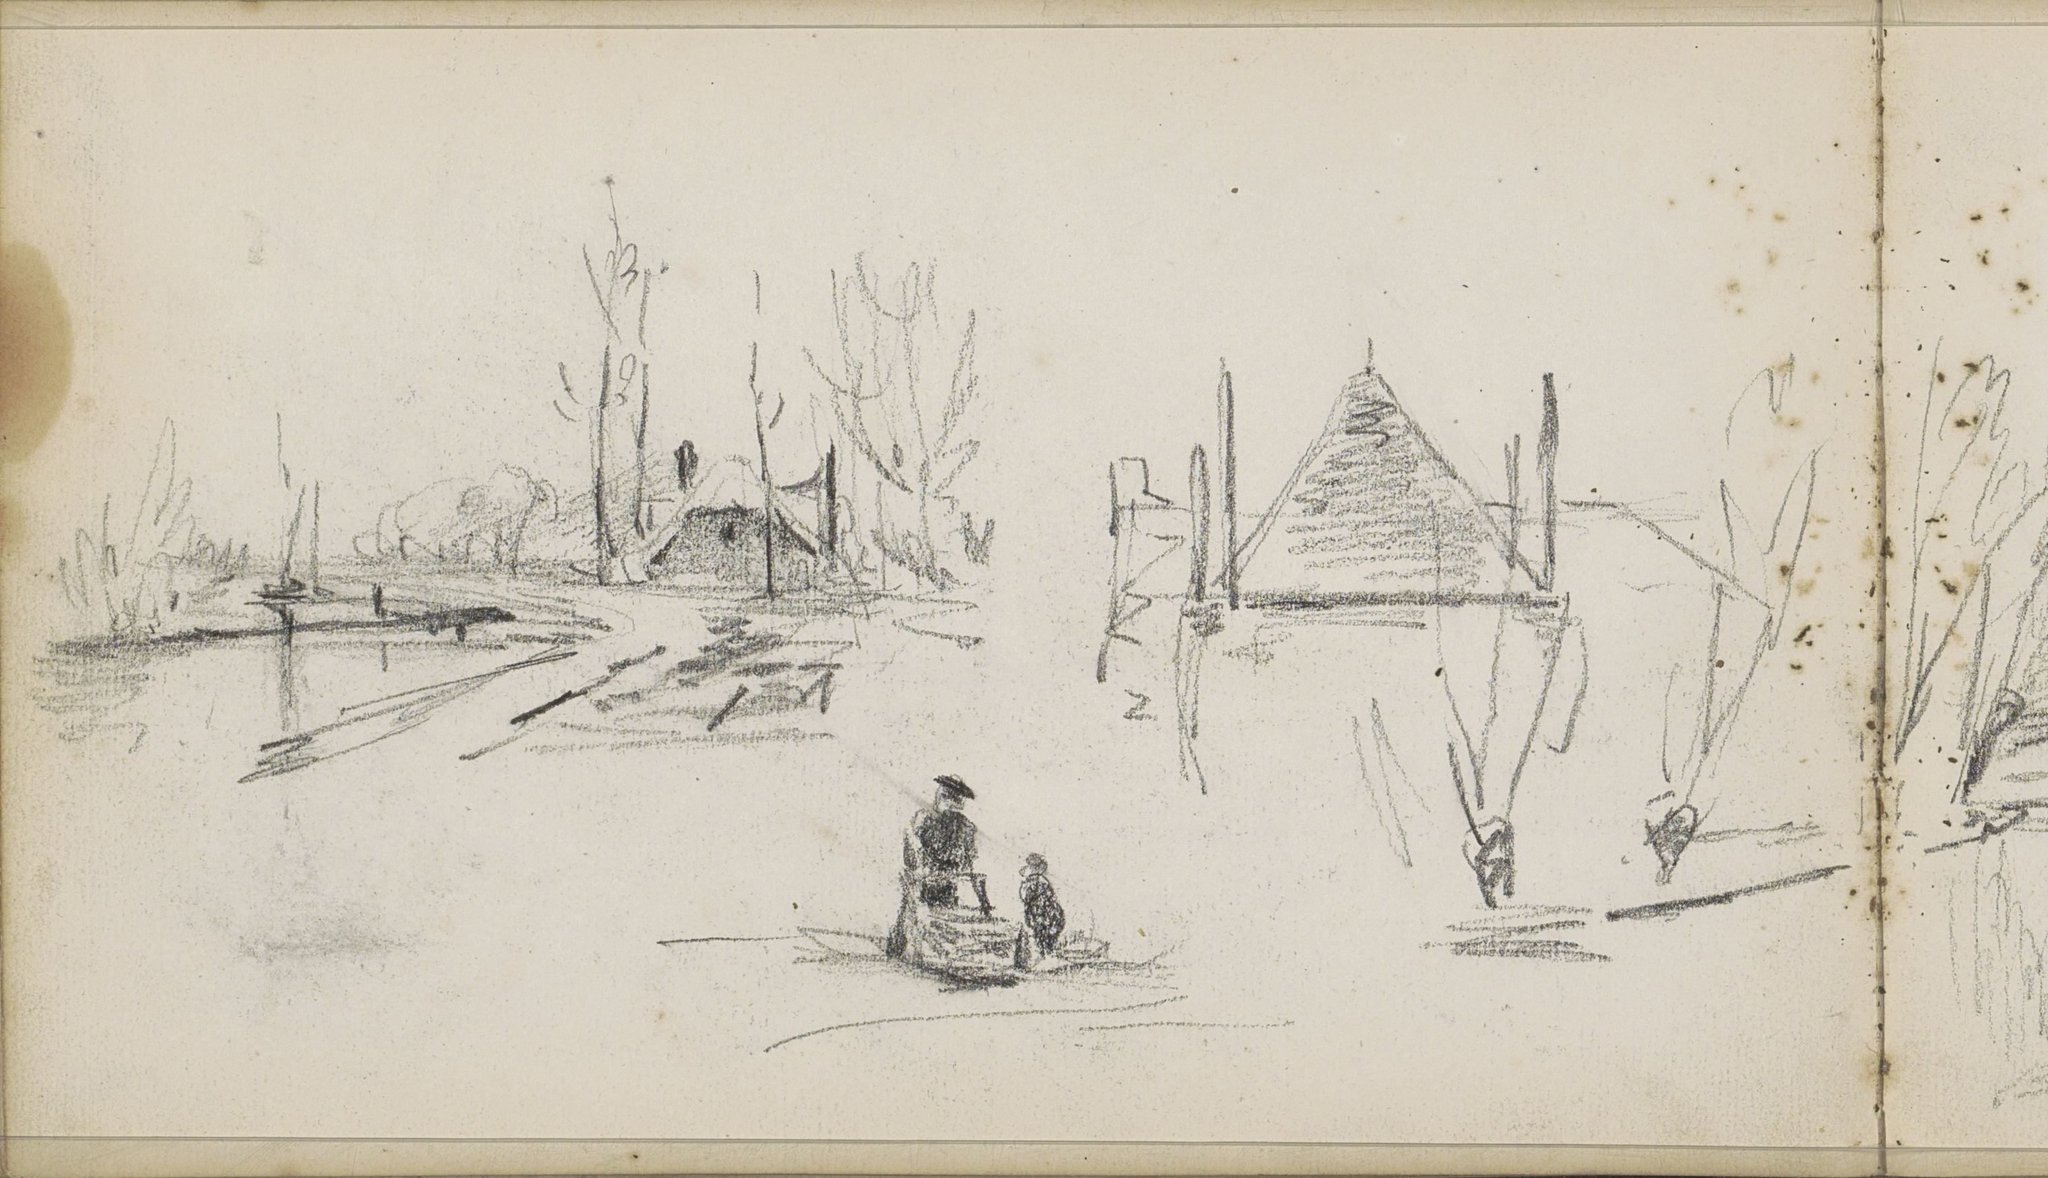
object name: sketchbook leaf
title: Boerderij langs een vaart, een huis en figuren met een slede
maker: willem cornelis rip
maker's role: draughtsman, painter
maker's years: 1856-1922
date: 1876-1877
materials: paper, pencil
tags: landscapes with waters, waterscapes, seascapes (in the temperate zone), sleigh, sledge (non-sport), farm (building)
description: Blad 26 verso uit een schetsboek met 41 bladen.